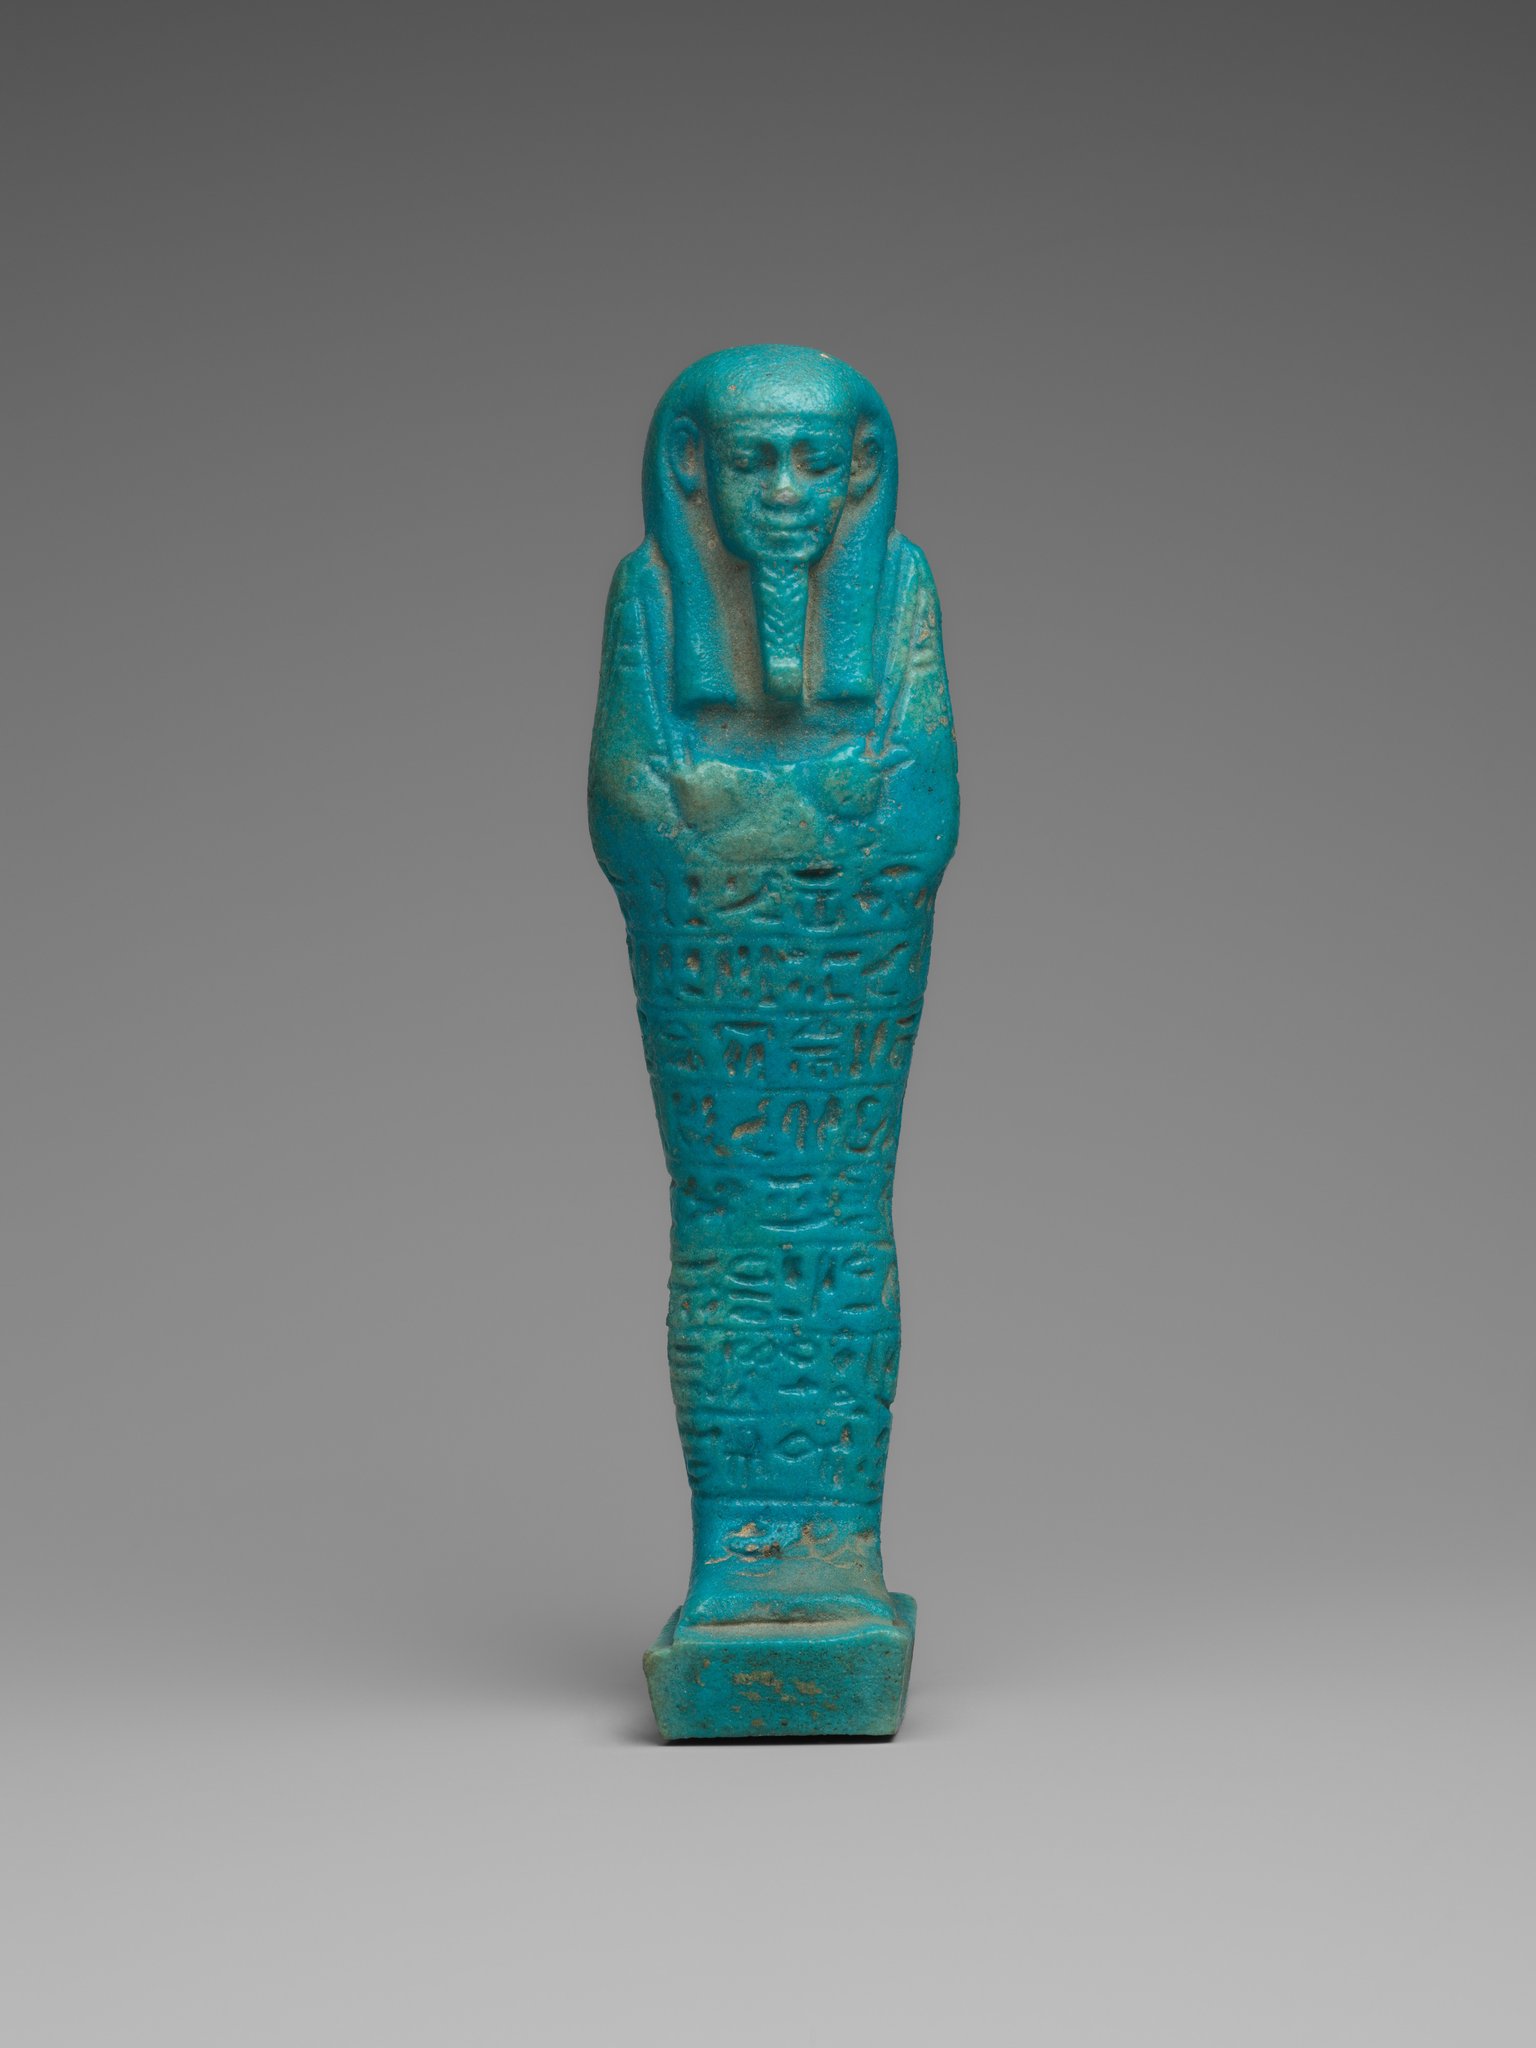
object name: shabti, wahibremhebyt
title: Shabti of Wahibrenethebsed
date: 664-332 BCE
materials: faience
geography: egypt